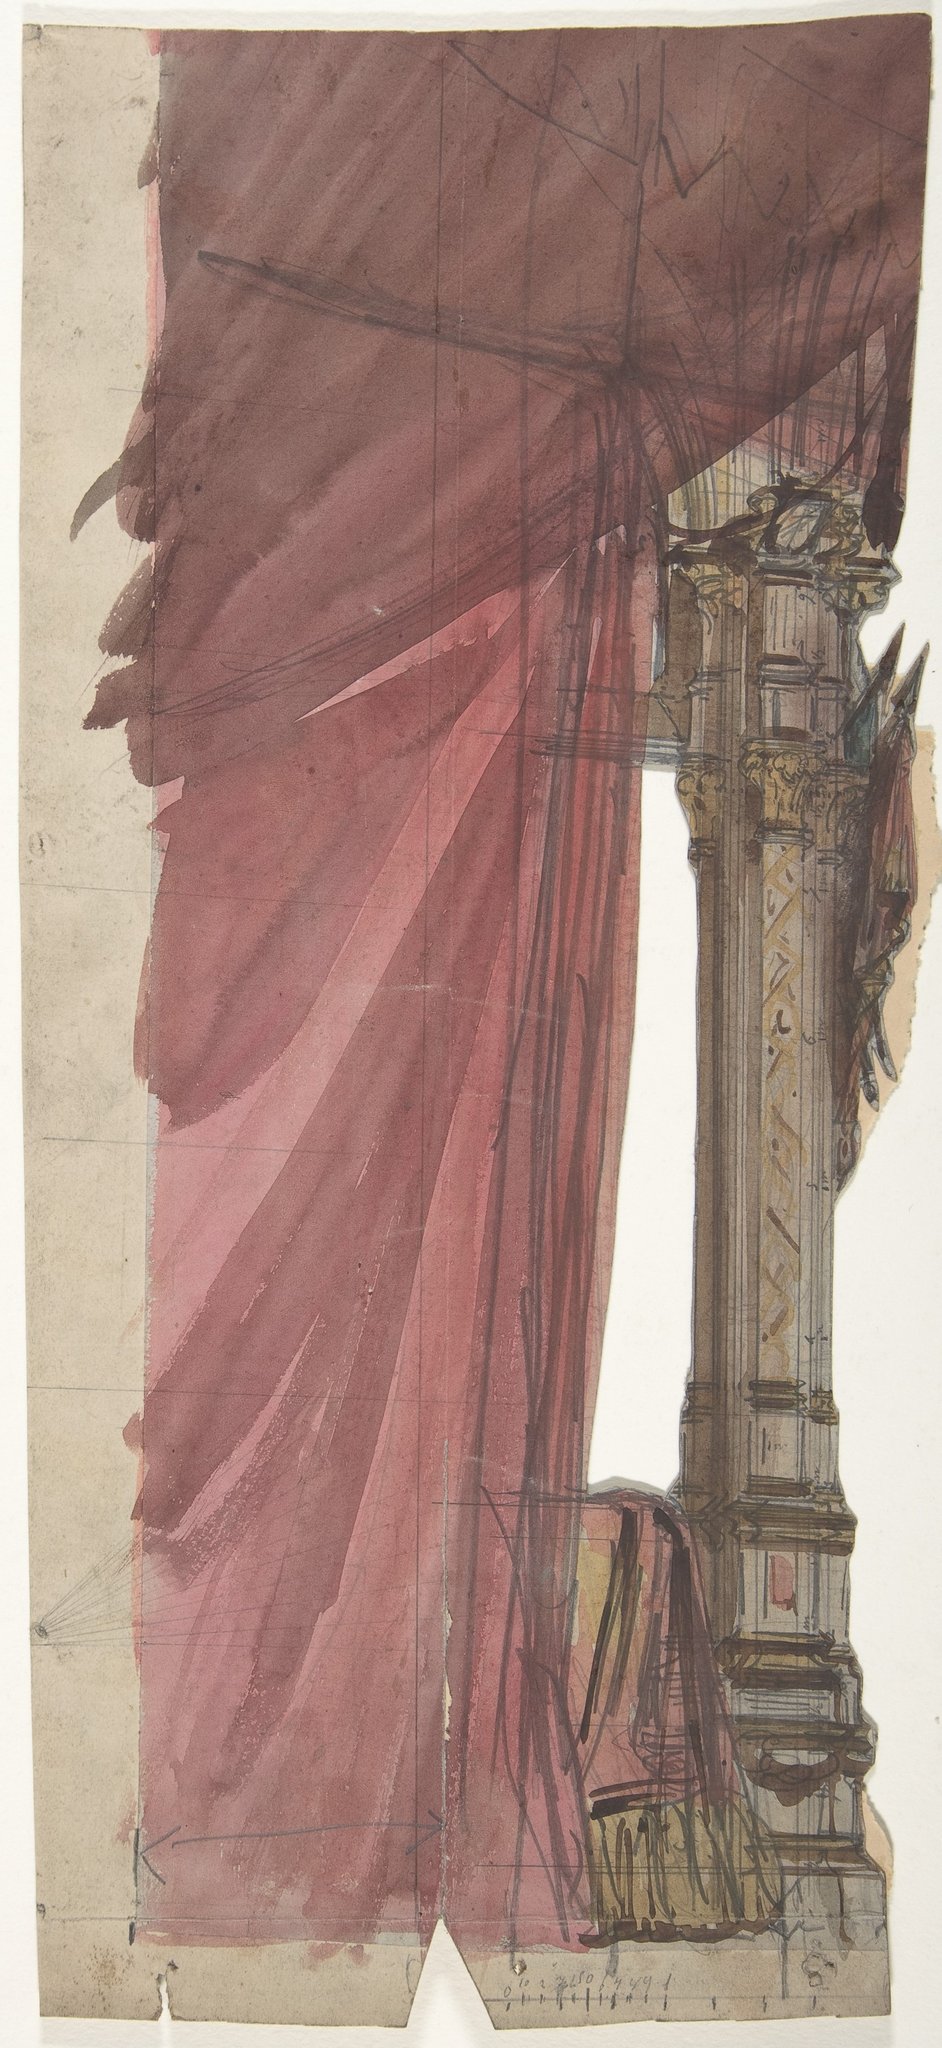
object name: drawing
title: Design for a Stage Set at the Opéra, Paris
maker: eugène cicéri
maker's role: artist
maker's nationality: french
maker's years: 1813-1890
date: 1830-1890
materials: graphite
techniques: brush, wash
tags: stage design